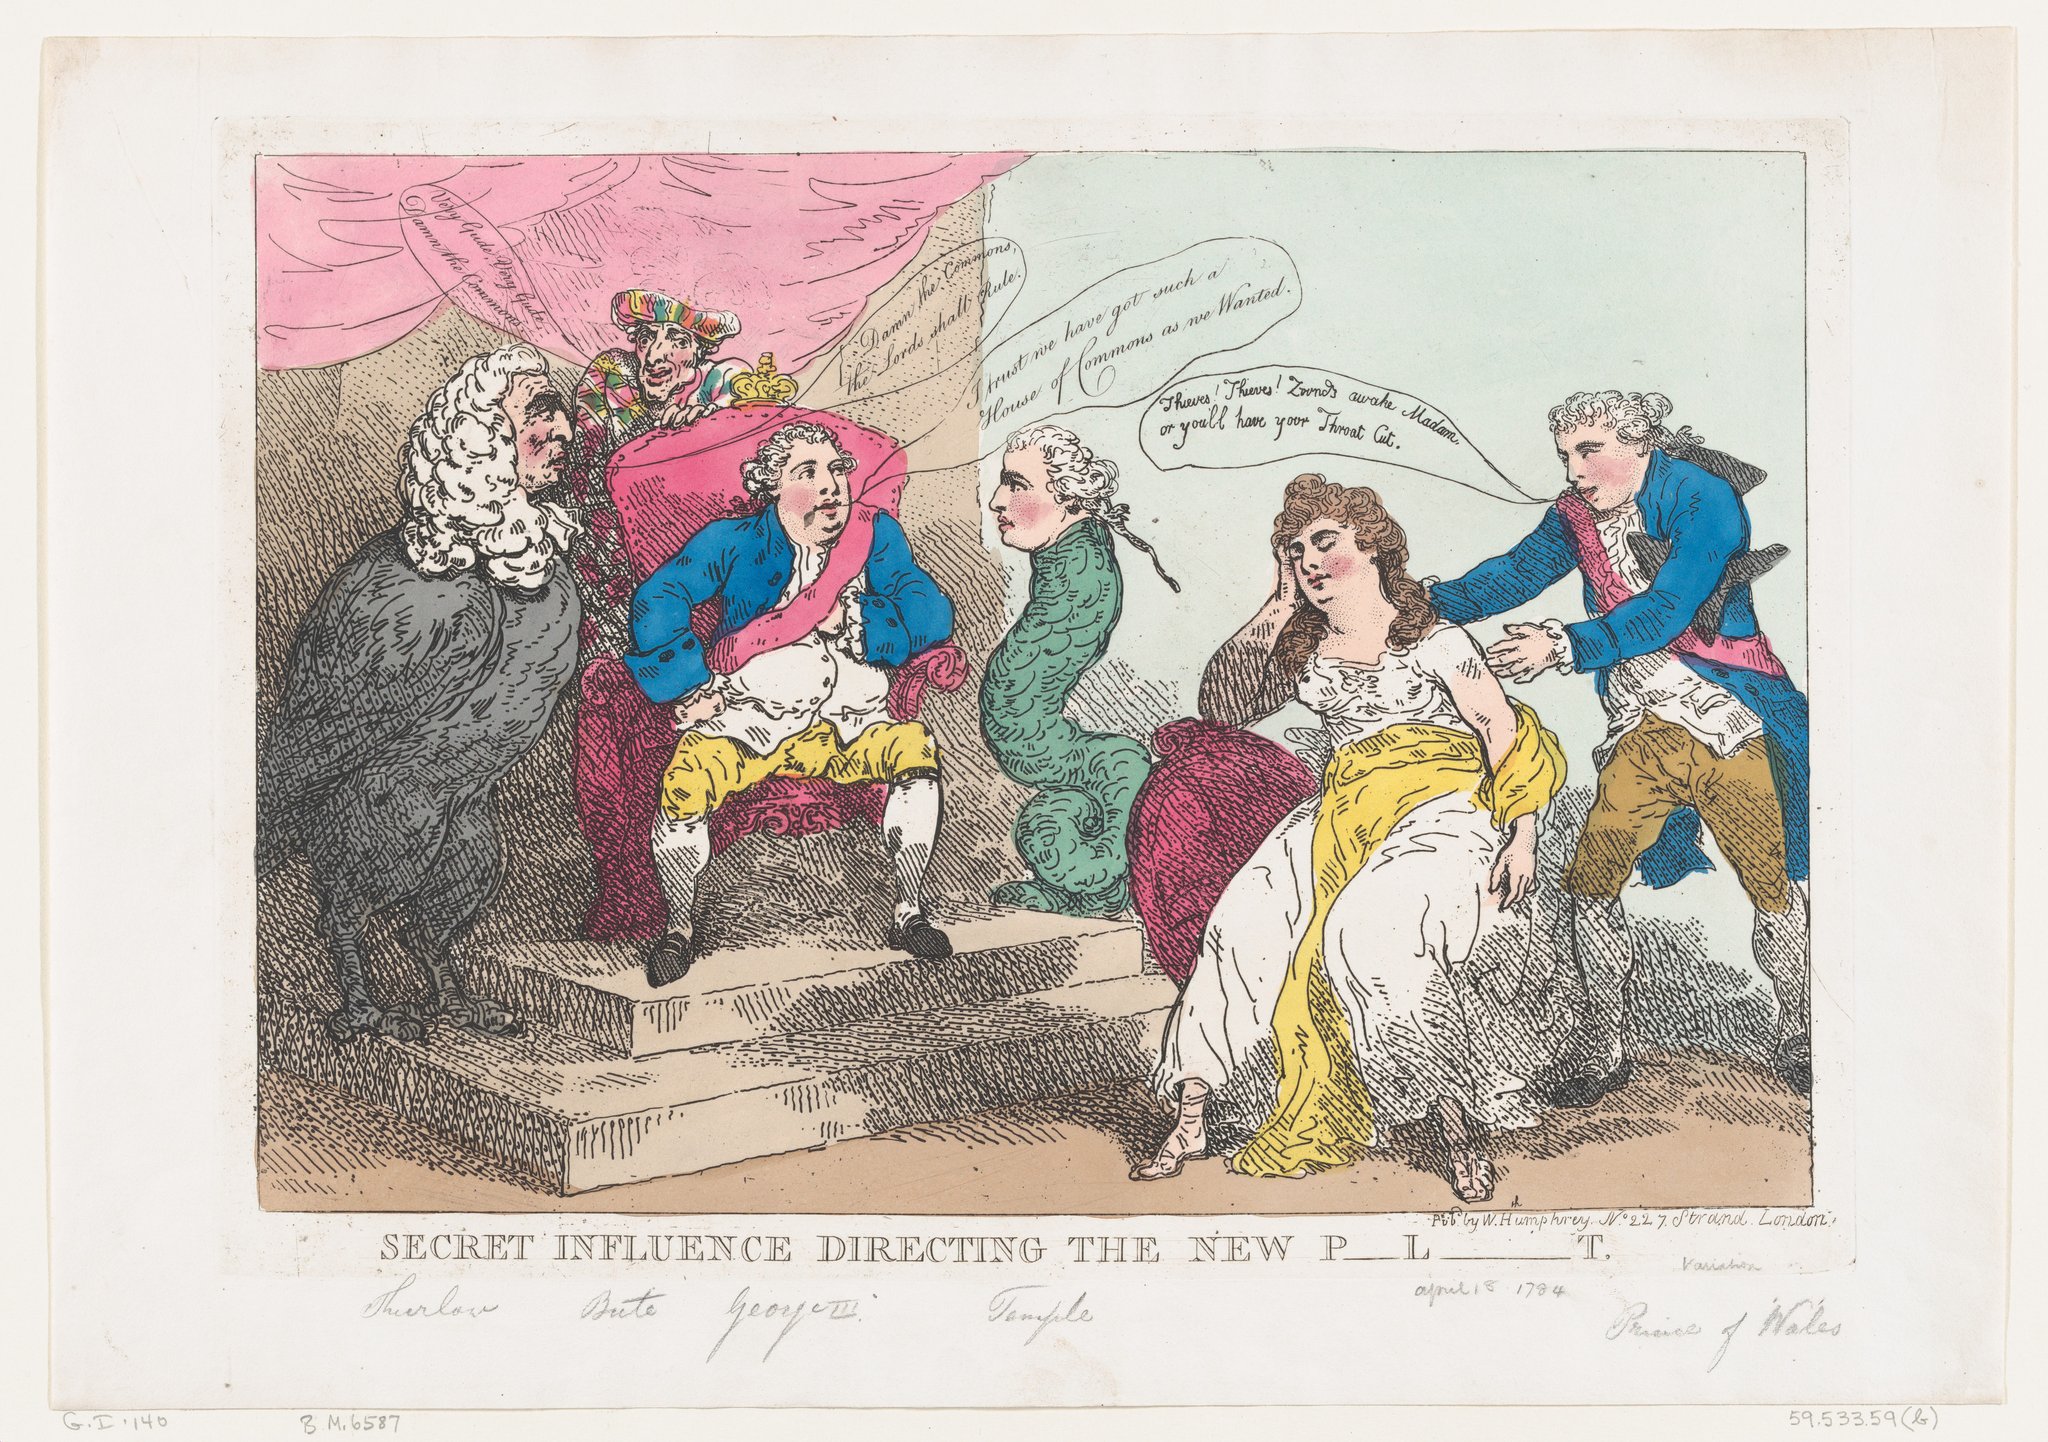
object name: print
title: Secret Influence Directing The New P-l-t [Parliament]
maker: thomas rowlandson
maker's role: artist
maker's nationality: british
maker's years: 1757-1827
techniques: etching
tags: satire,men,women